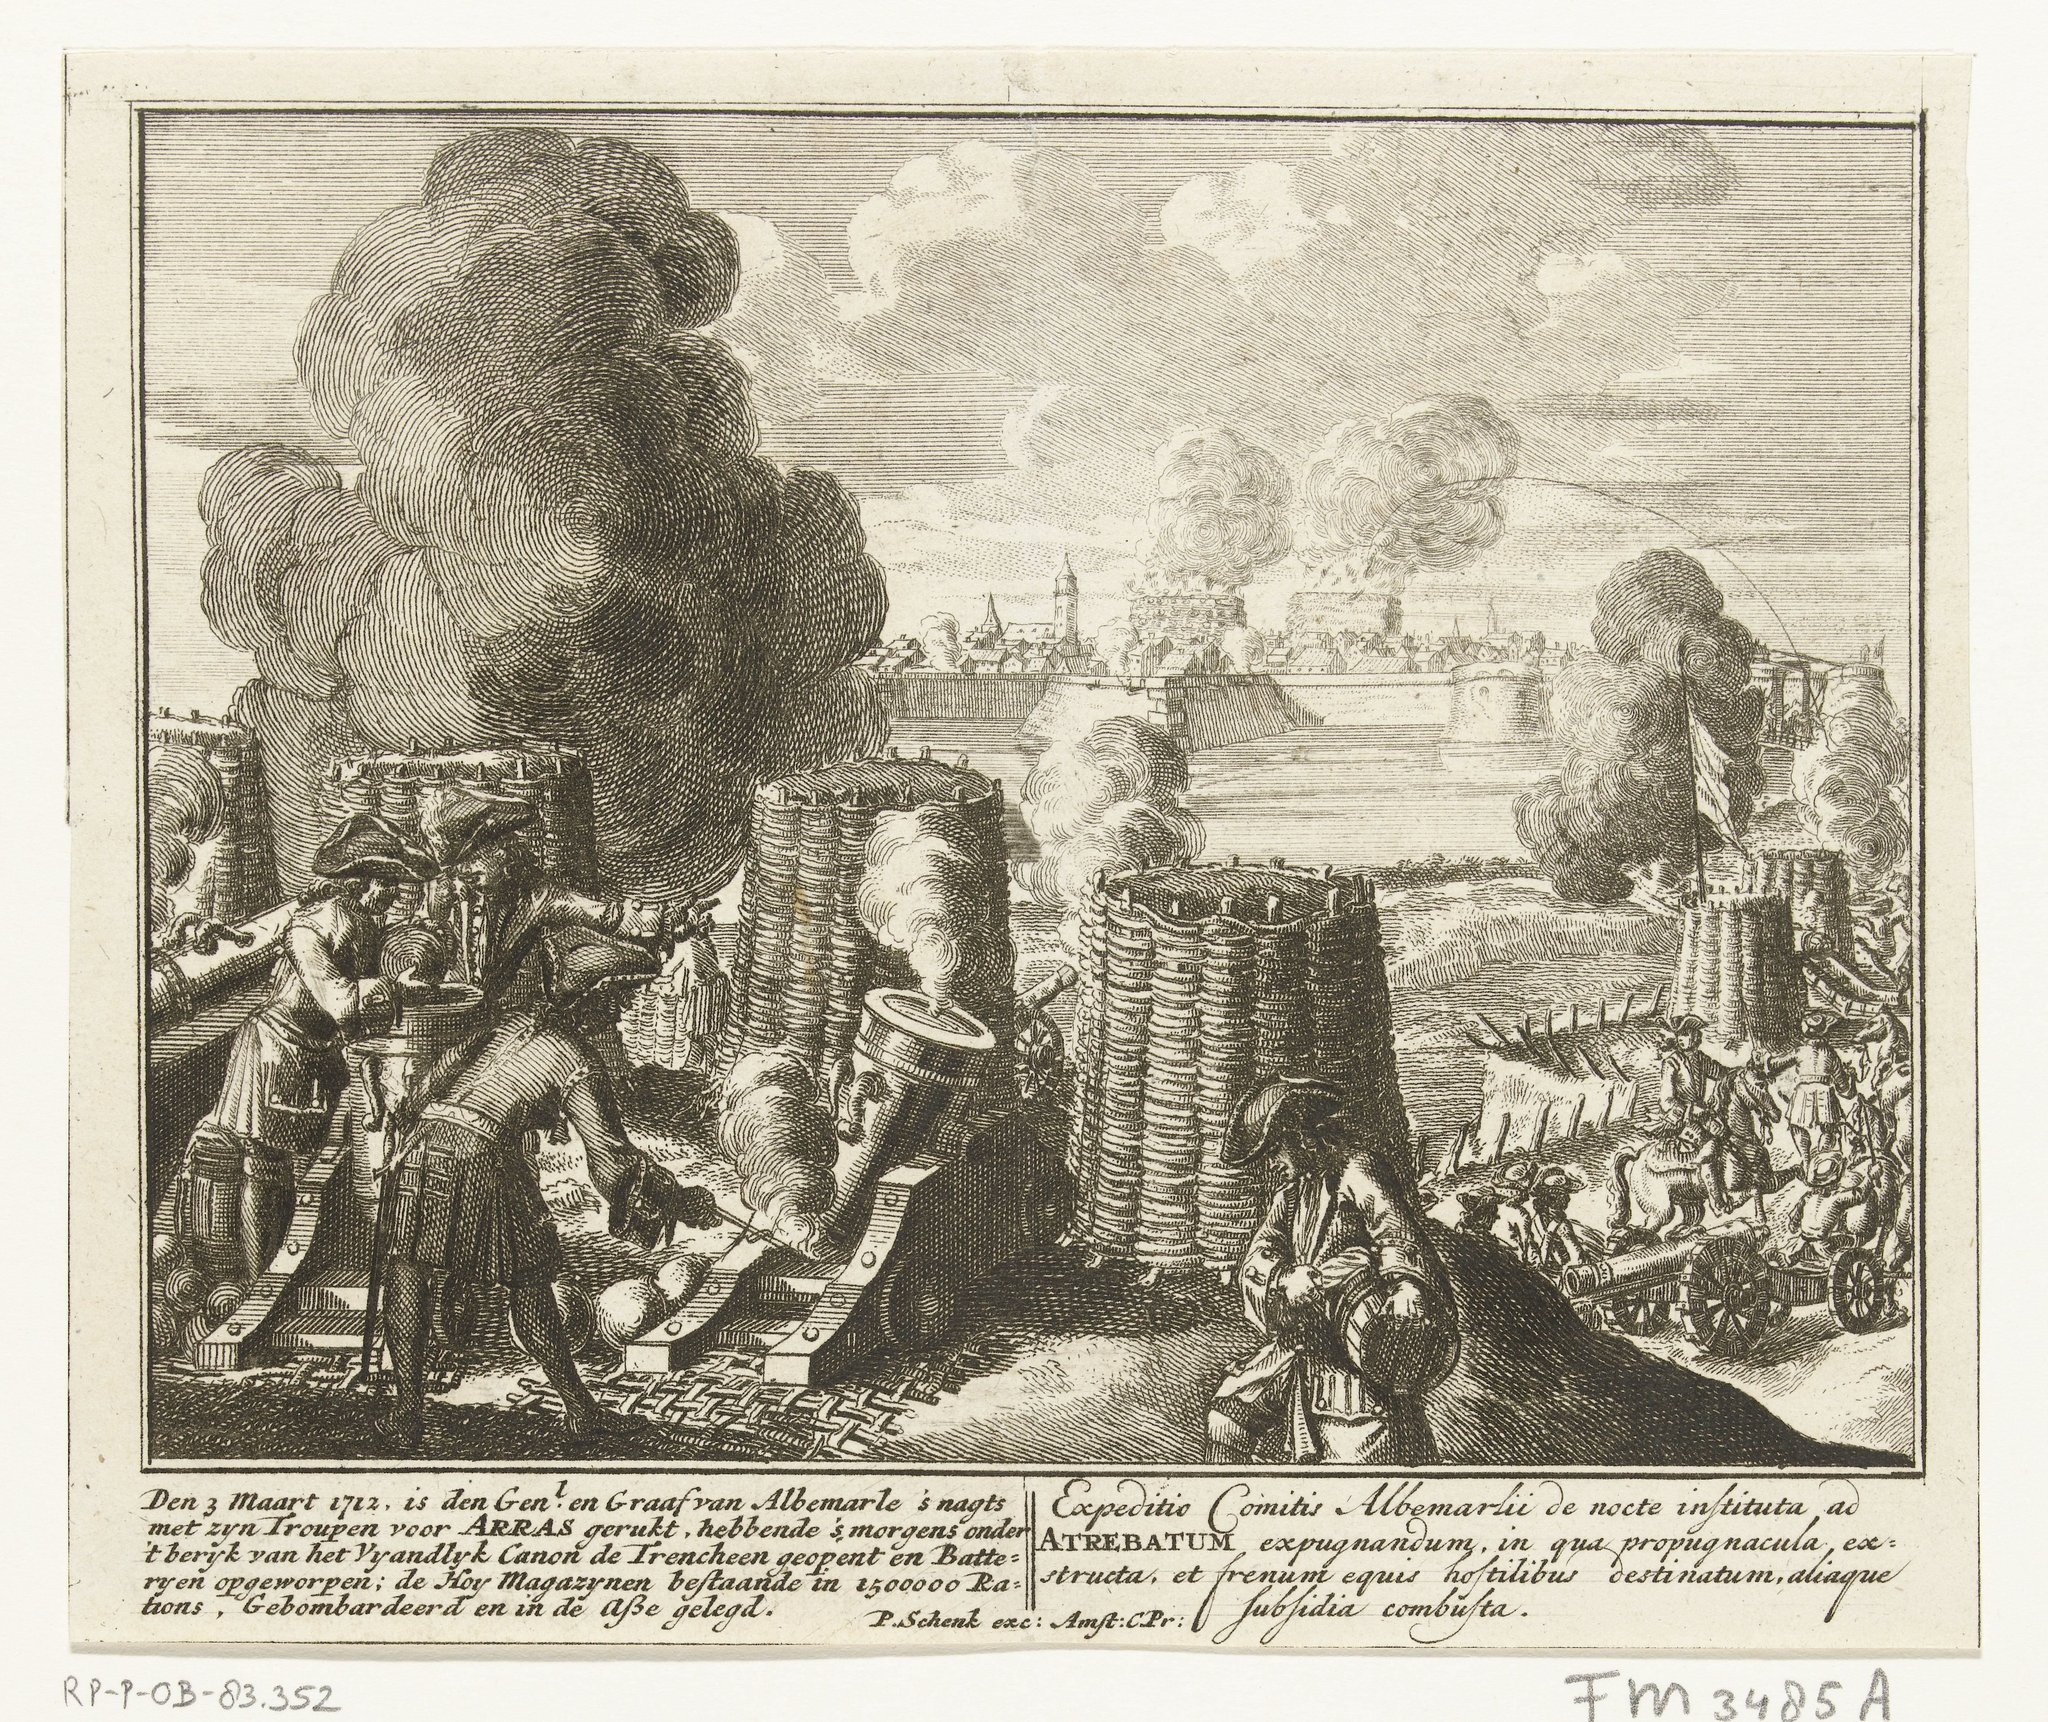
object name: print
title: Den 3 Maart 1712, is den Genl. en Graaf van Albemarle 's nagts met zyn Troupen voor Arras gerukt (...)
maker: pieter schenk (i)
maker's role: print maker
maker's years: 1660-1711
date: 1712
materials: paper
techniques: etching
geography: northern netherlands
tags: bombardment ~ siege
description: Bombardement van Arras door de Geallieerden, vanaf 3 maart 1712. Met onderschriften in het Nederlands en Latijn. Fragment van een grote plaat met negen voorstellingen van gebeurtenissen uit het jaar 1712 van de Spaanse Successieoorlog.